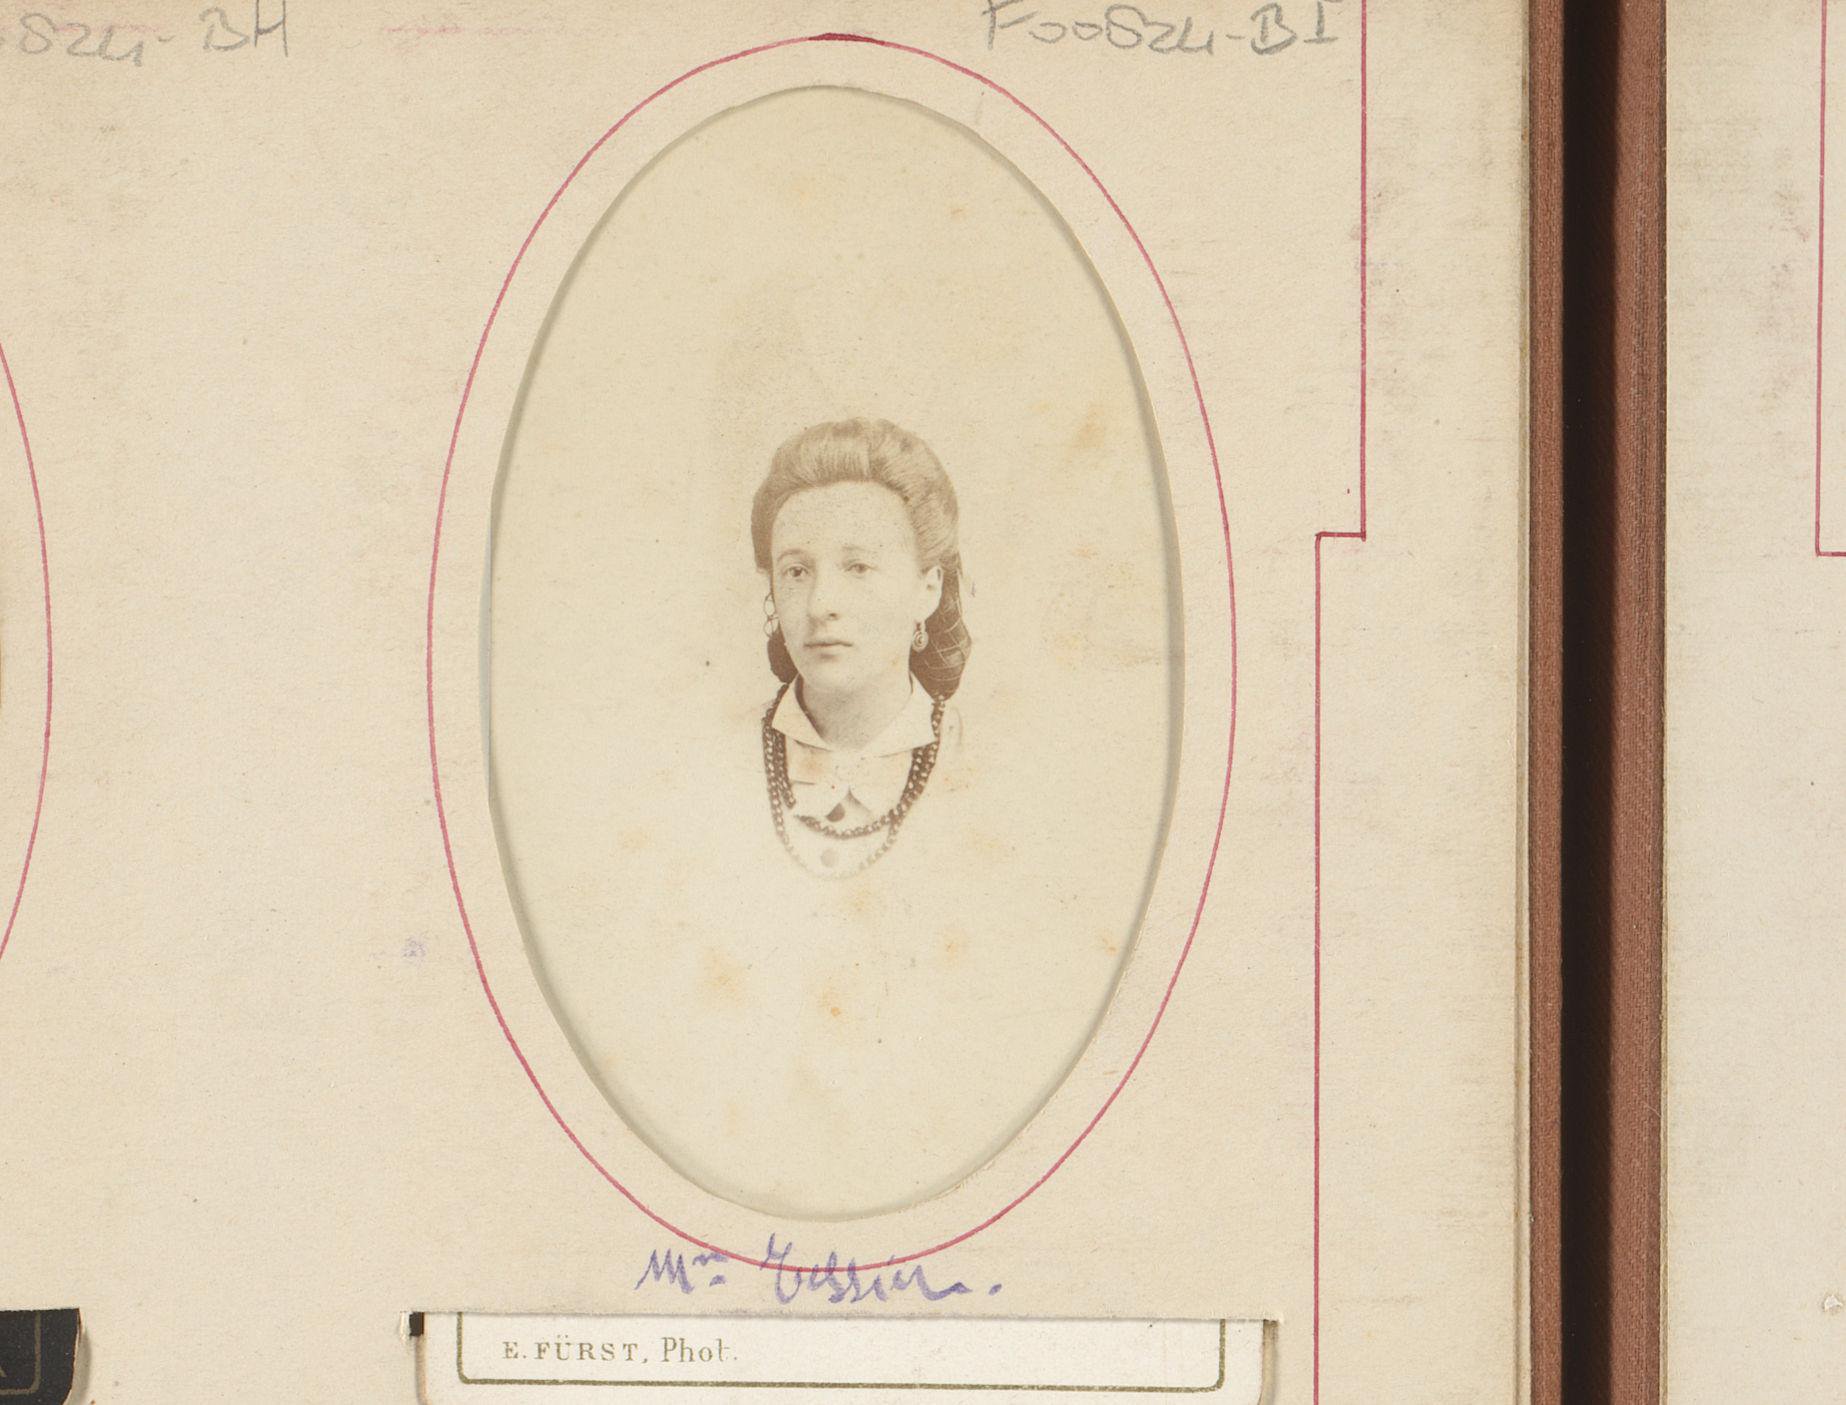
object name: photograph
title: Portret van een vrouw, aangeduid als Mme. Tessin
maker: émile fürst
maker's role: fotograaf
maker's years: 1834-1922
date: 1864-1886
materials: cardboard, paper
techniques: albumen print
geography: nantes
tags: adult woman, anonymous historical person portrayed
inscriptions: address: ‘10, Rue du Calvaire, 10/ NANTES’, inscription: ‘Tous les Clichés sont conservés’